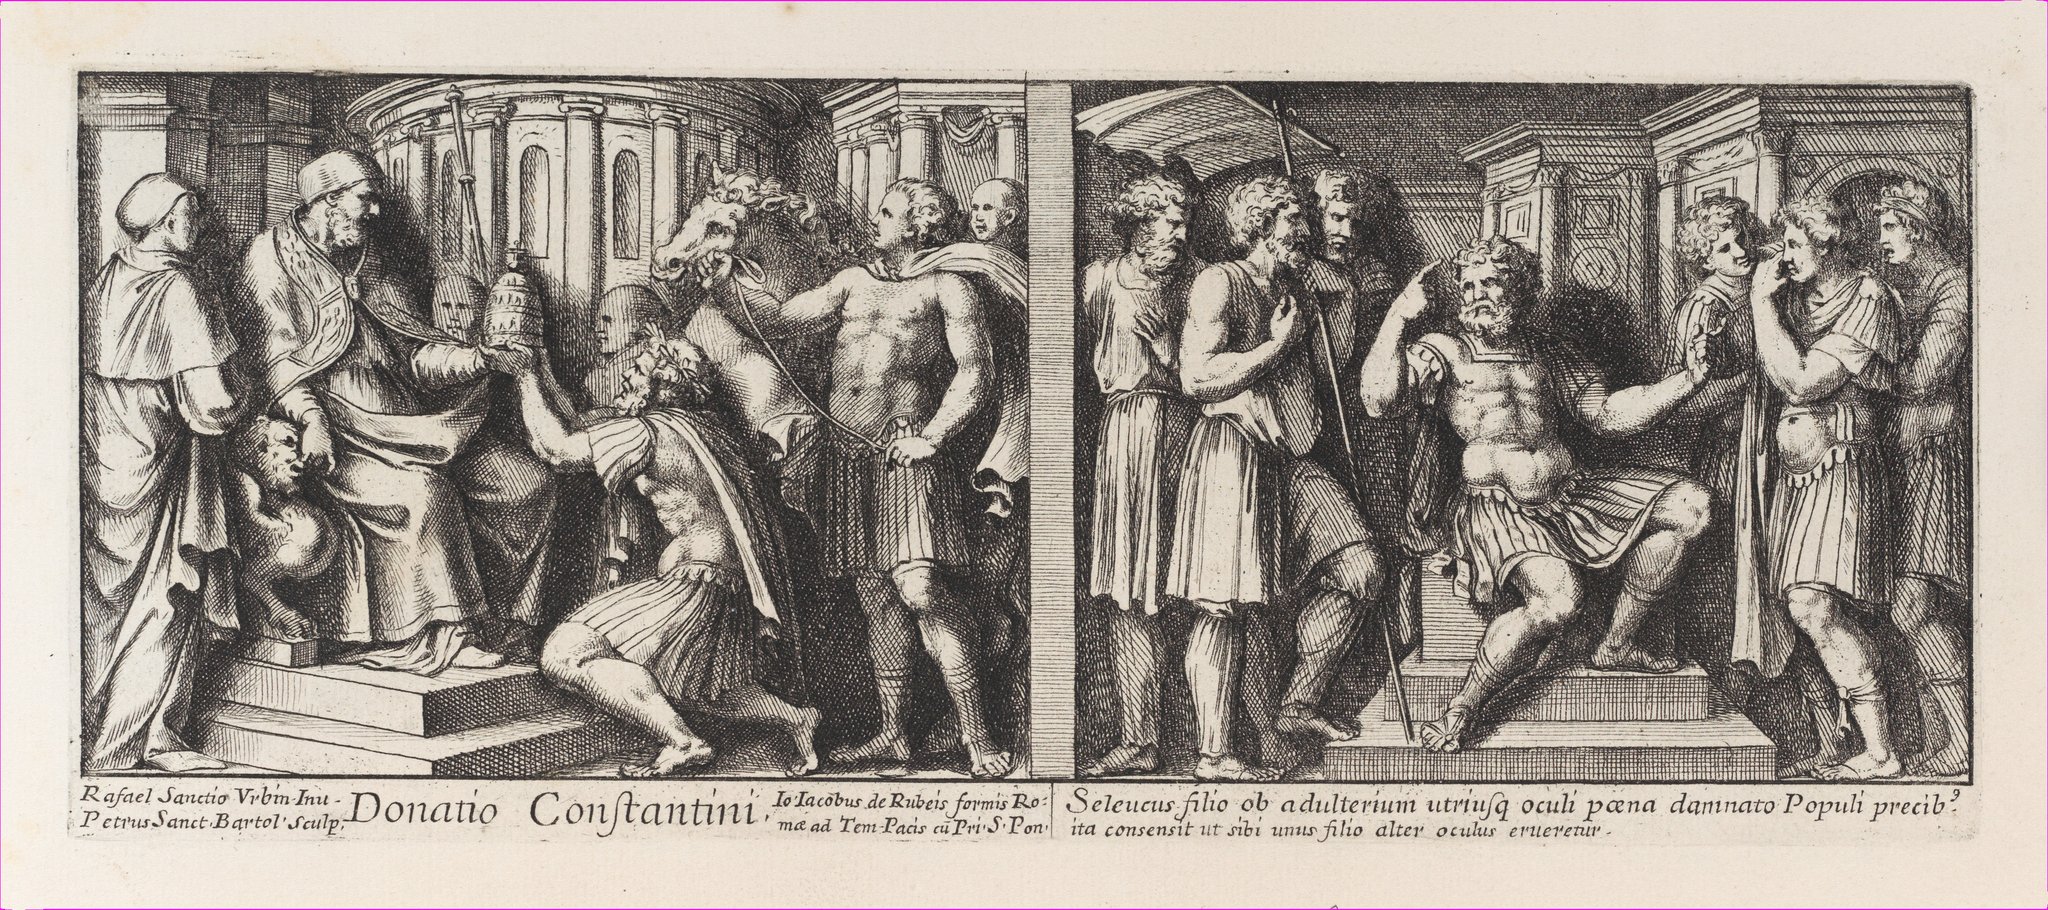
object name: print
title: Two Biblical Scenes: Constantine donating the City of Rome to Pope Sylvester at left, after Raphael's Stanza di Eliodoro and The Judgement of Seleucids at right, after Raphael's Stanza della Segnatura, from a series of 15 plates depicting Raphael's works for the Vatican stanze and the Sistine Chapel tapestries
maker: pietro santi bartoli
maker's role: artist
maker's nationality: italian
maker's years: 1615-1700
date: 1650-1670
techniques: etching